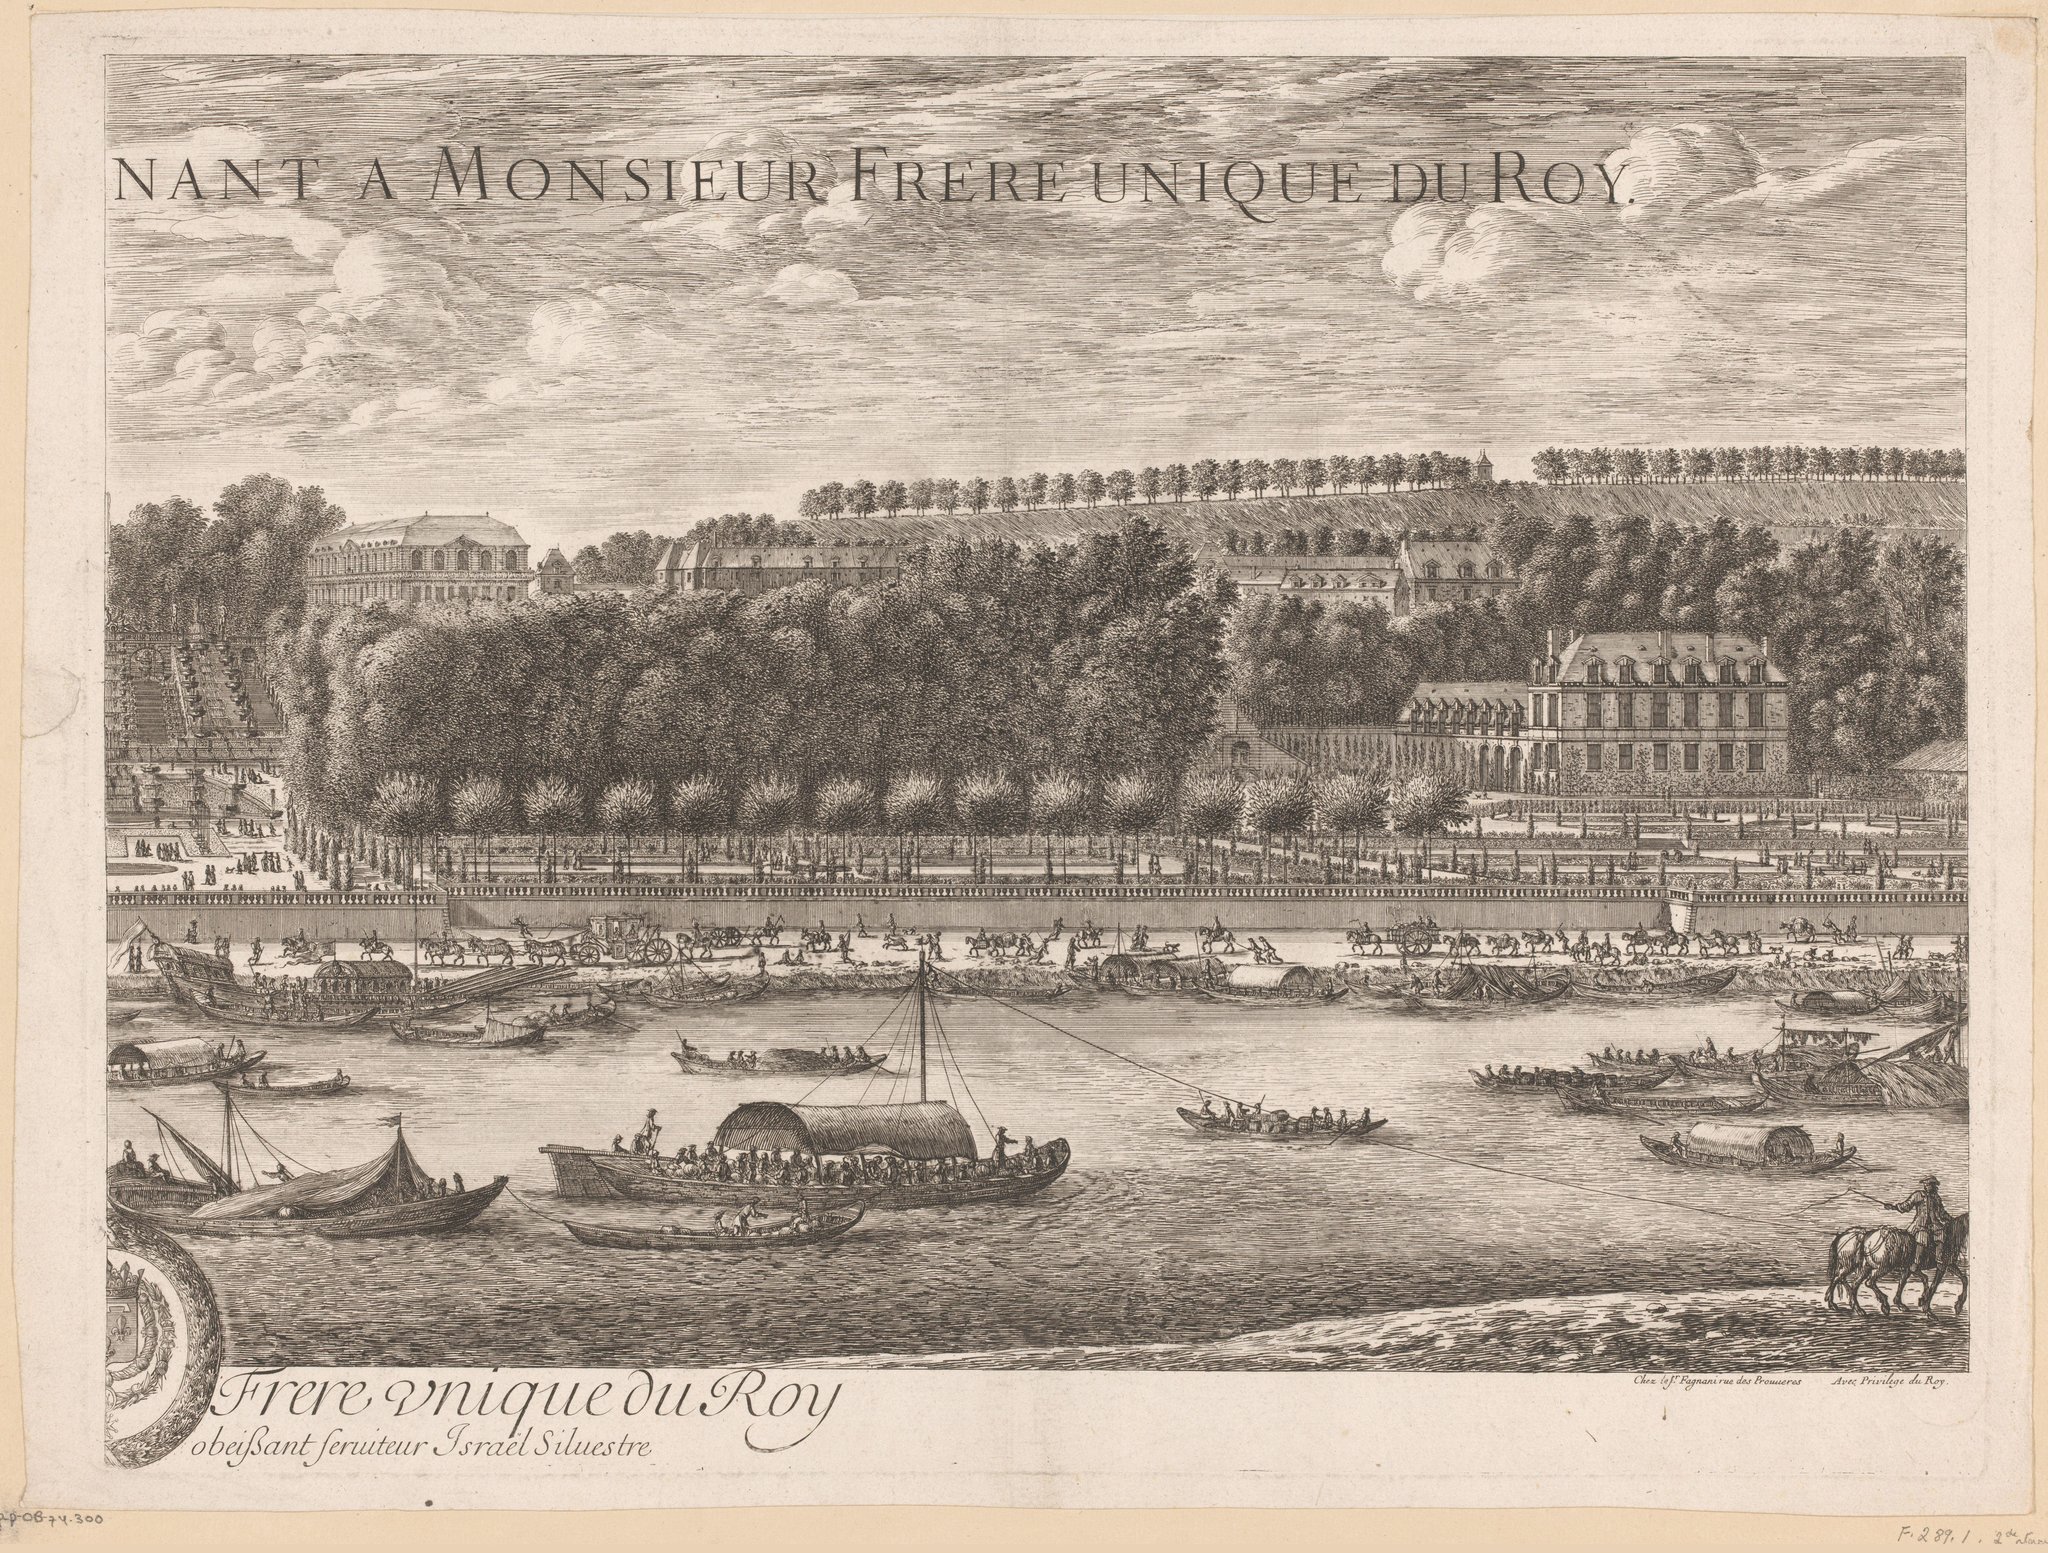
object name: print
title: Veue de la maison de St. Cloud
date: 1671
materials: paper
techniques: engraving, etching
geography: france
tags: city-view, and landscape with man-made constructions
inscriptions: collector's mark: Lugt 240